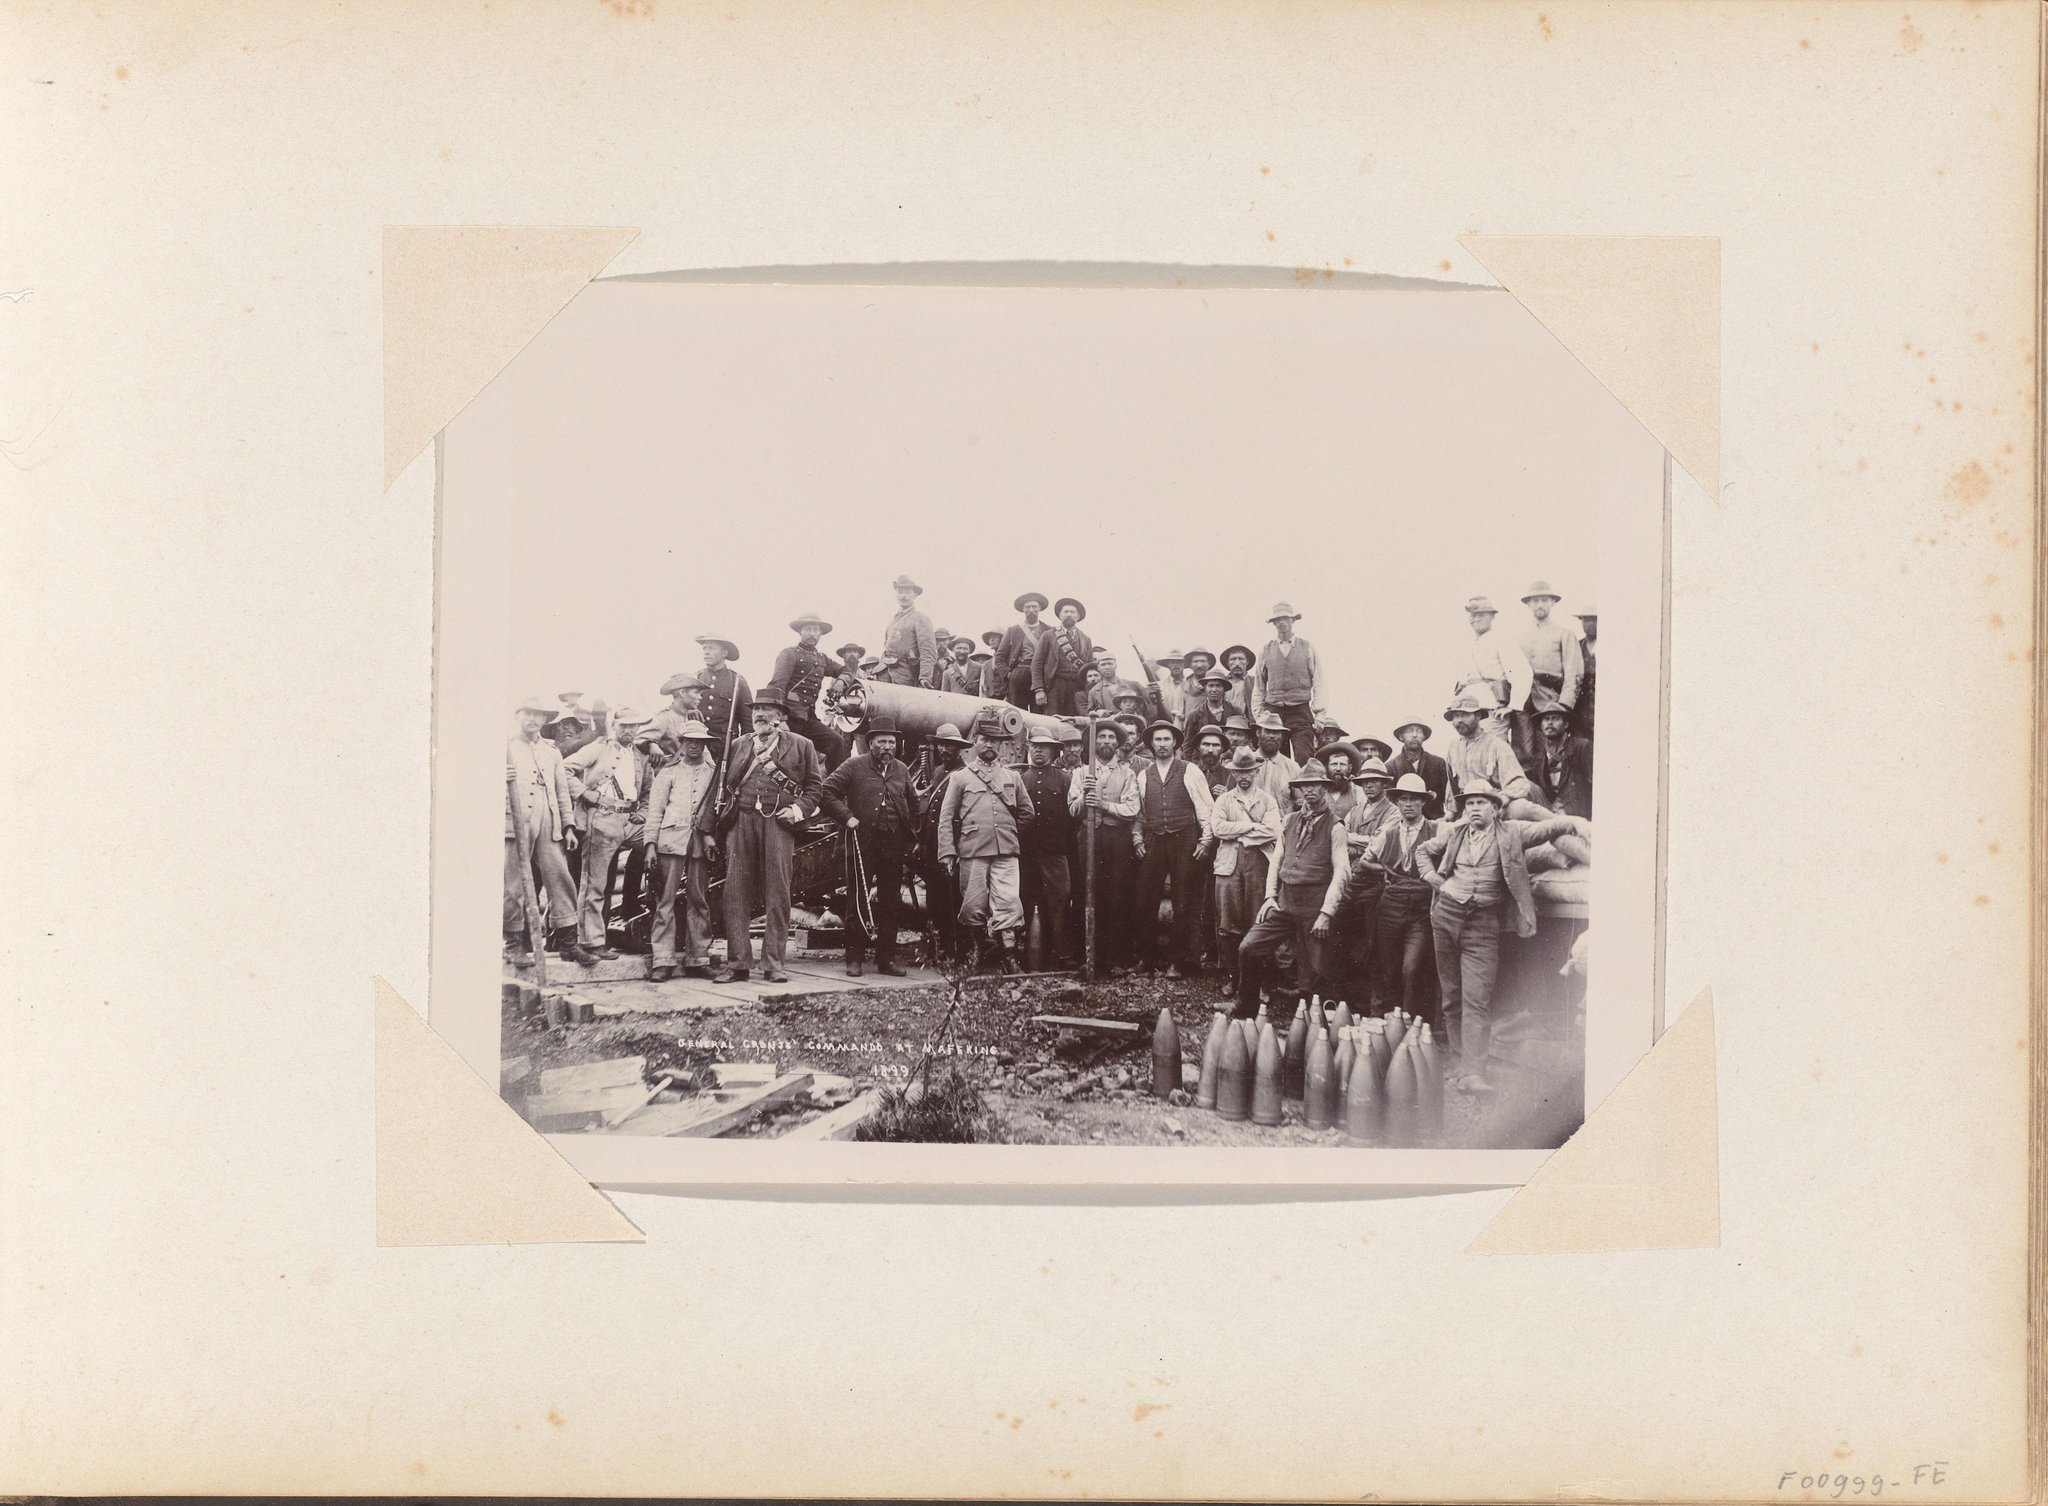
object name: photograph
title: General Cronje Commando at Mafeking 1899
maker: david barnett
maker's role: fotograaf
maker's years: -1964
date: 1899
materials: paper, photographic support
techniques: gelatin silver print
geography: mafeking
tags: warfare; military affairs (+ weapons)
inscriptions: inscription: ‘Cronjé is met de zweep in zijn hand.’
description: Onderdeel van Album met 191 foto's van een reis naar en door Zuid-Afrika.